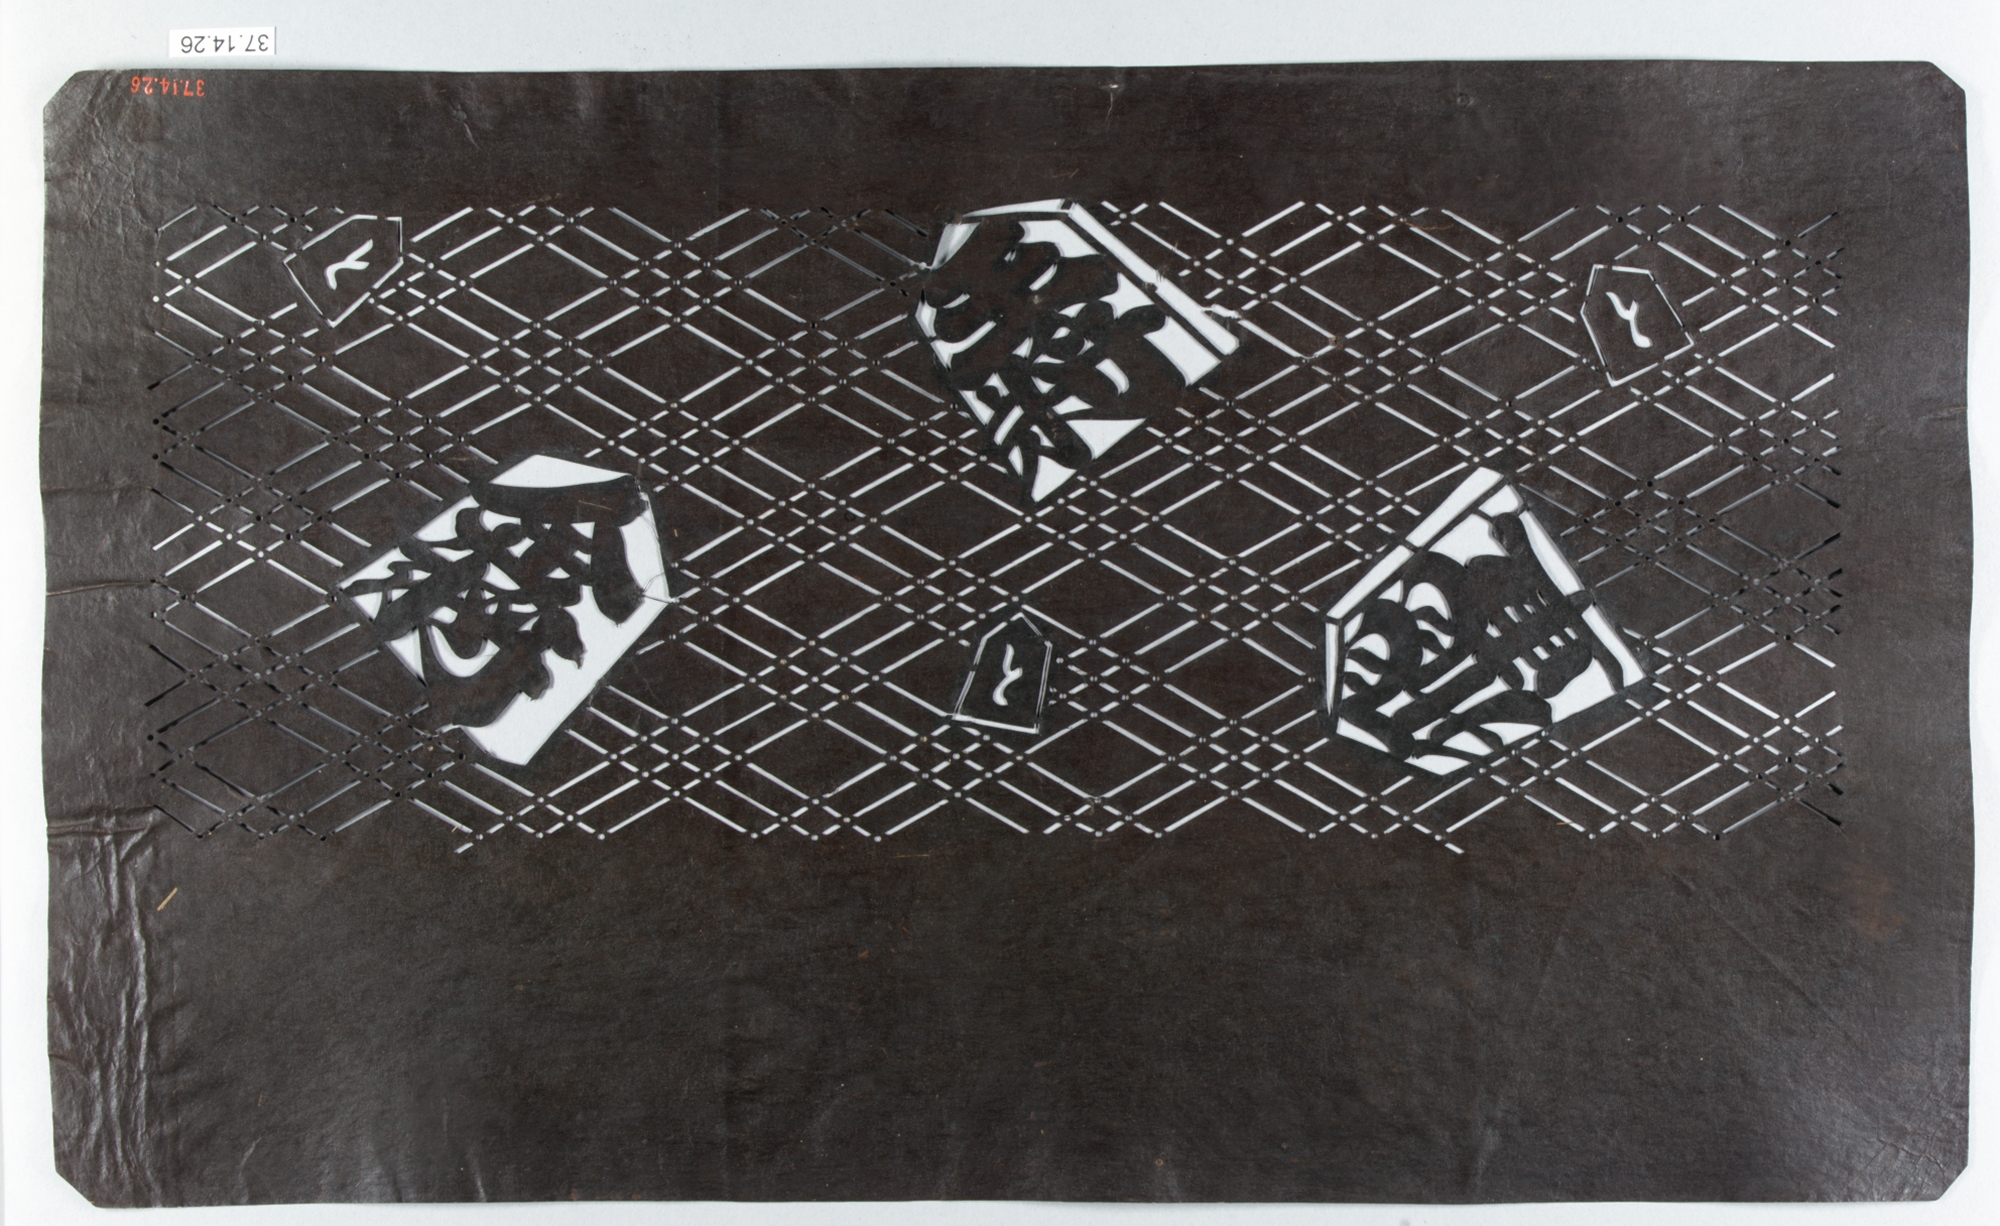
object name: stencil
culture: japanese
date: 1801-1833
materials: paper